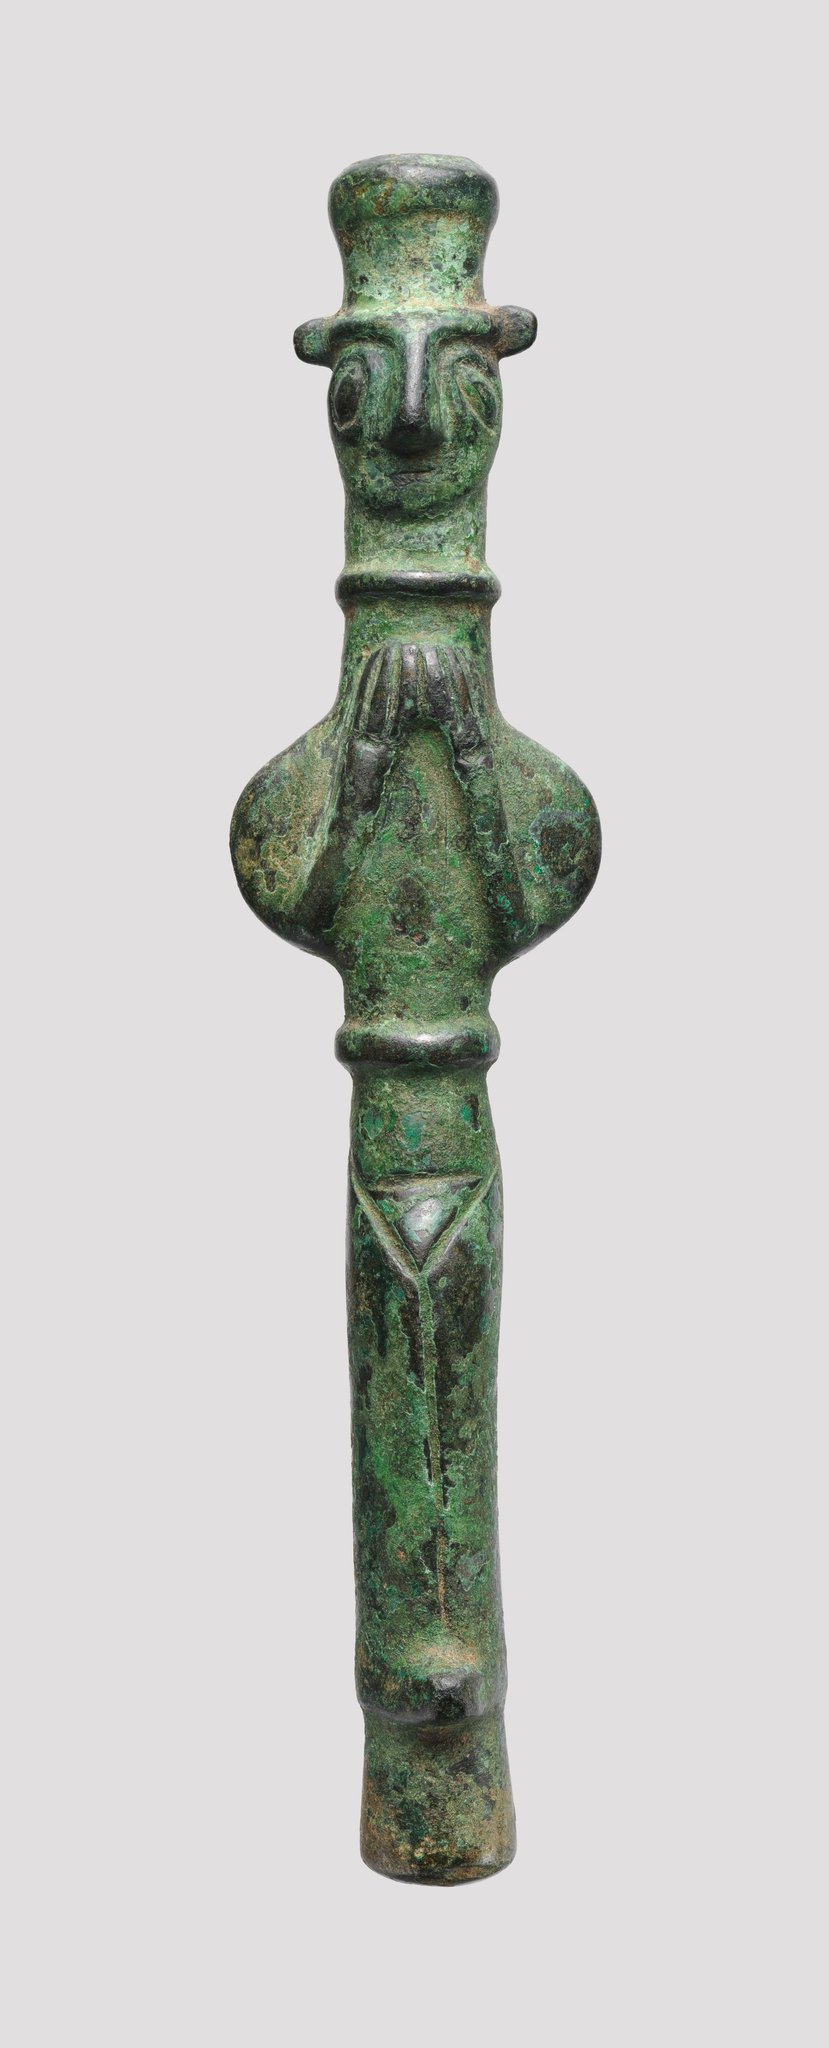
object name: sculpture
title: Anthropomorphic "fertility" tube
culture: iranian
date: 800-601 BCE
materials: bronze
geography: iran, probably from luristan